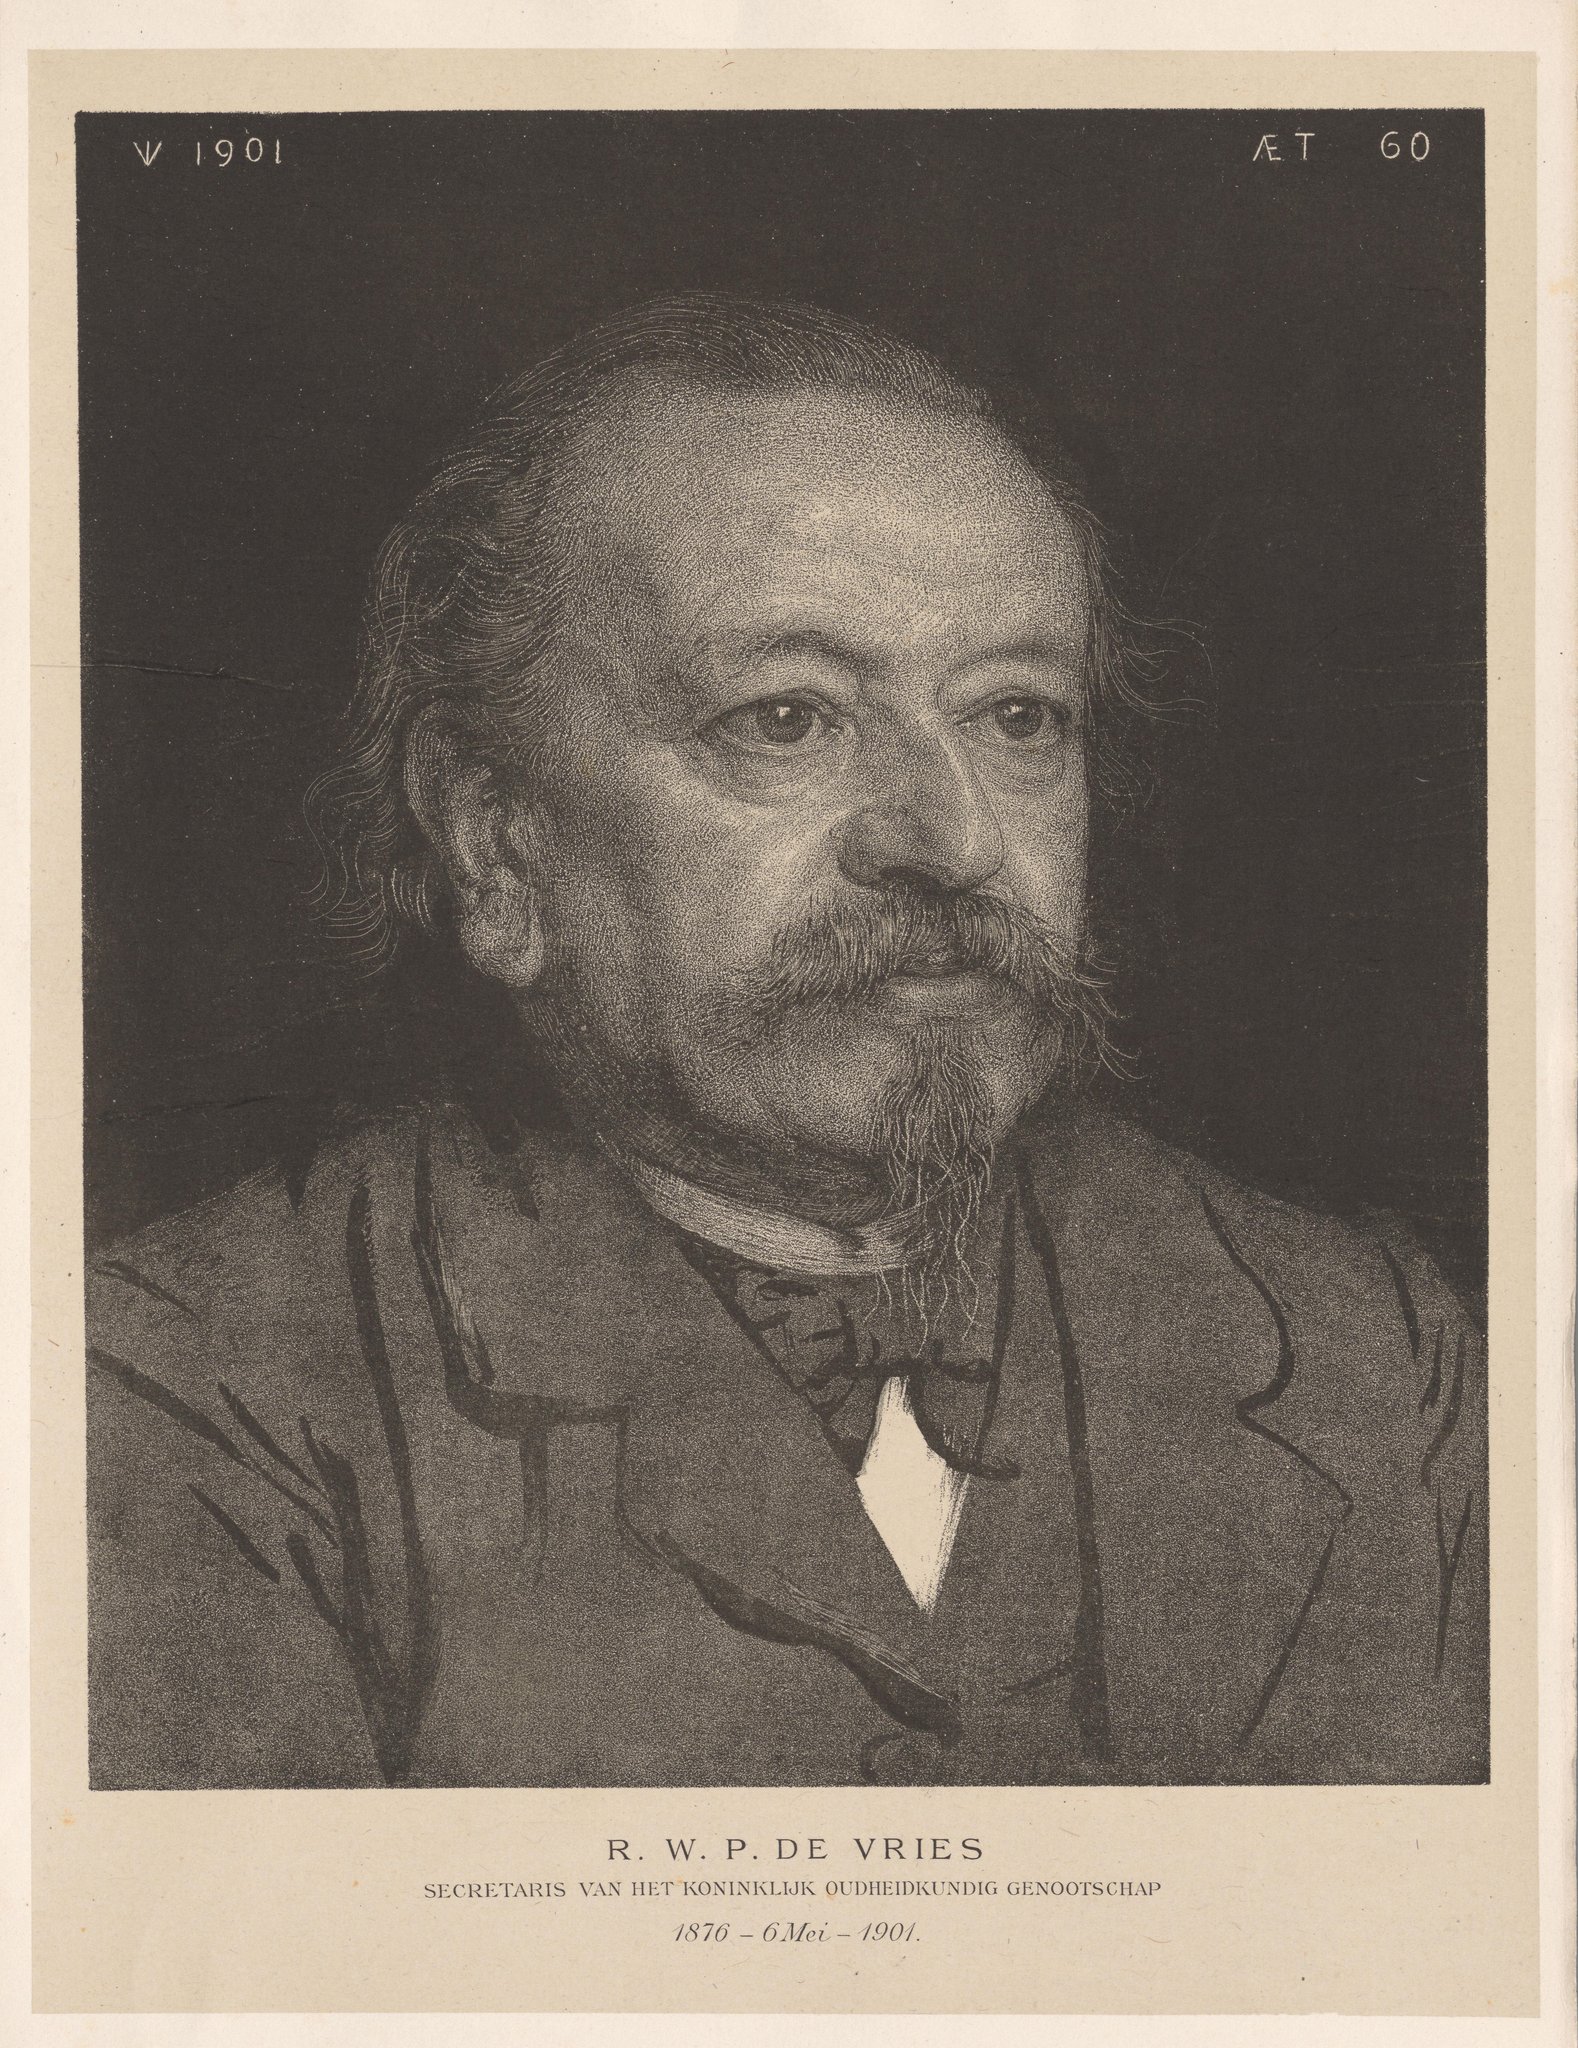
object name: print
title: Portret van Reinier Willem Petrus de Vries op 60-jarige leeftijd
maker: jan veth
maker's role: designer, draughtsman, painter, print maker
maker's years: 1864-1925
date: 1901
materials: paper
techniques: lithograph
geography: netherlands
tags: amsterdam, auctioneer, publisher, reinier willem petrus de vries (1841-1919), historical persons, art collector, book-shop, bookseller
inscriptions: collector's mark: Lugt 2233